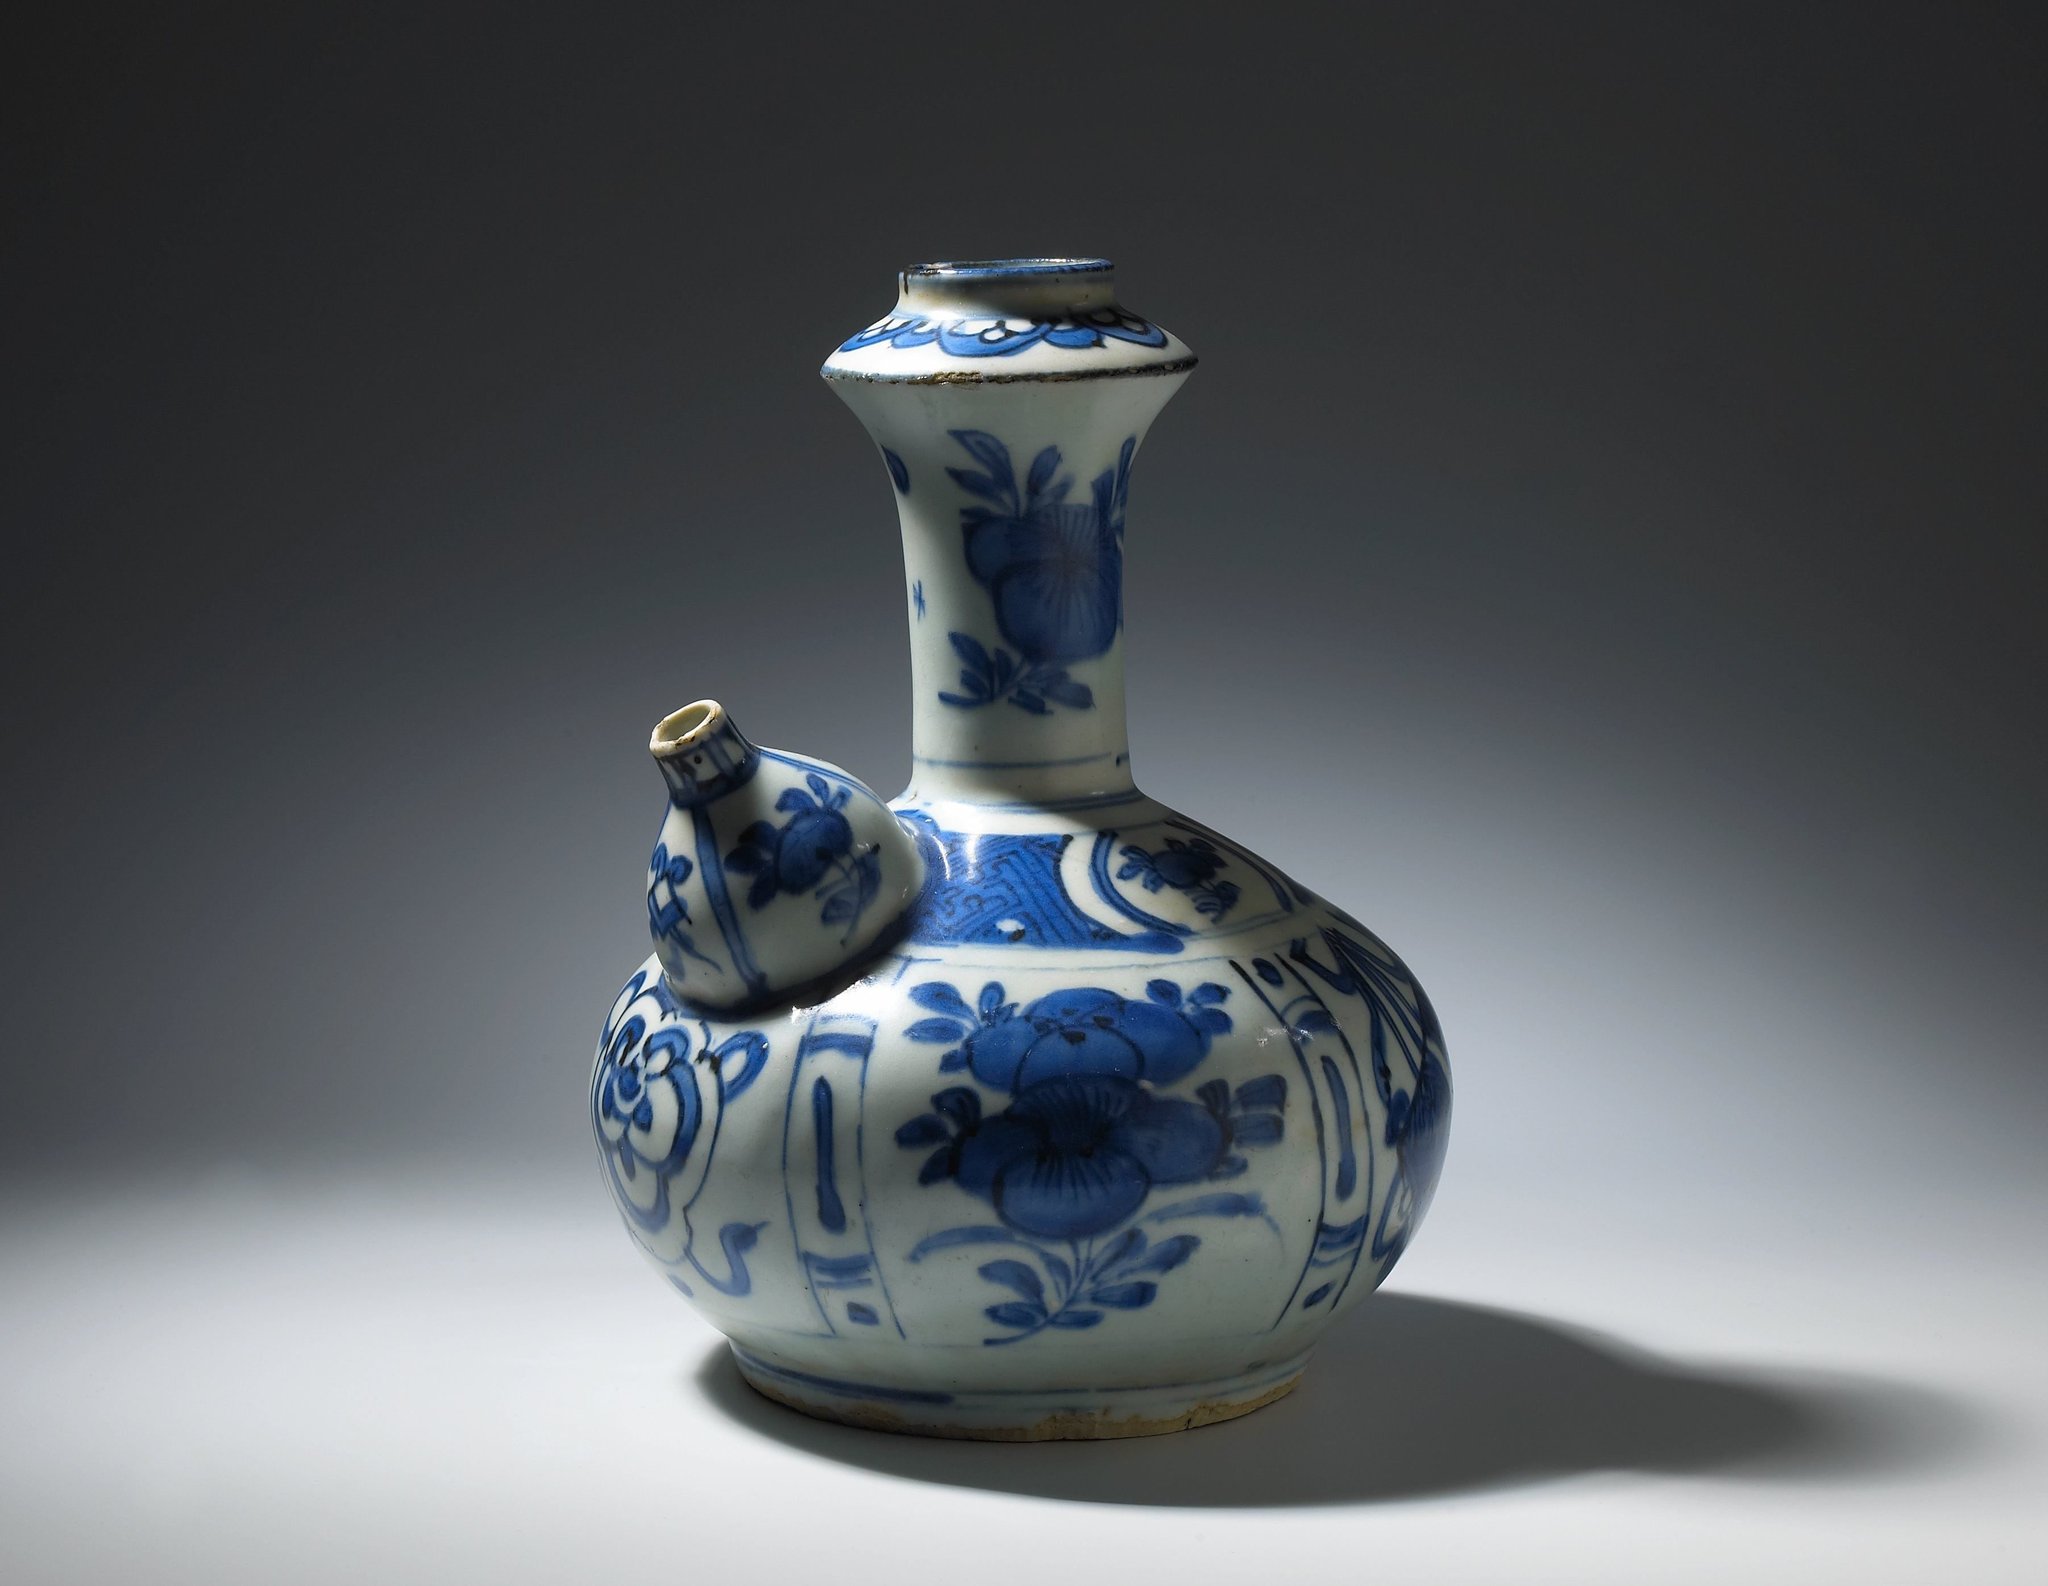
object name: kendi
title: Kendi with flowering plants and auspicious motifs in a panel decoration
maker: Anonymous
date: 1600-1649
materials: cobalt, glaze, paint, porcelain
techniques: firing, turning, vitrification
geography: china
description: Kendi. China. First half 17th century. Porcelain, decorated in blue underglaze. Given by Mr and Mrs Korteling.